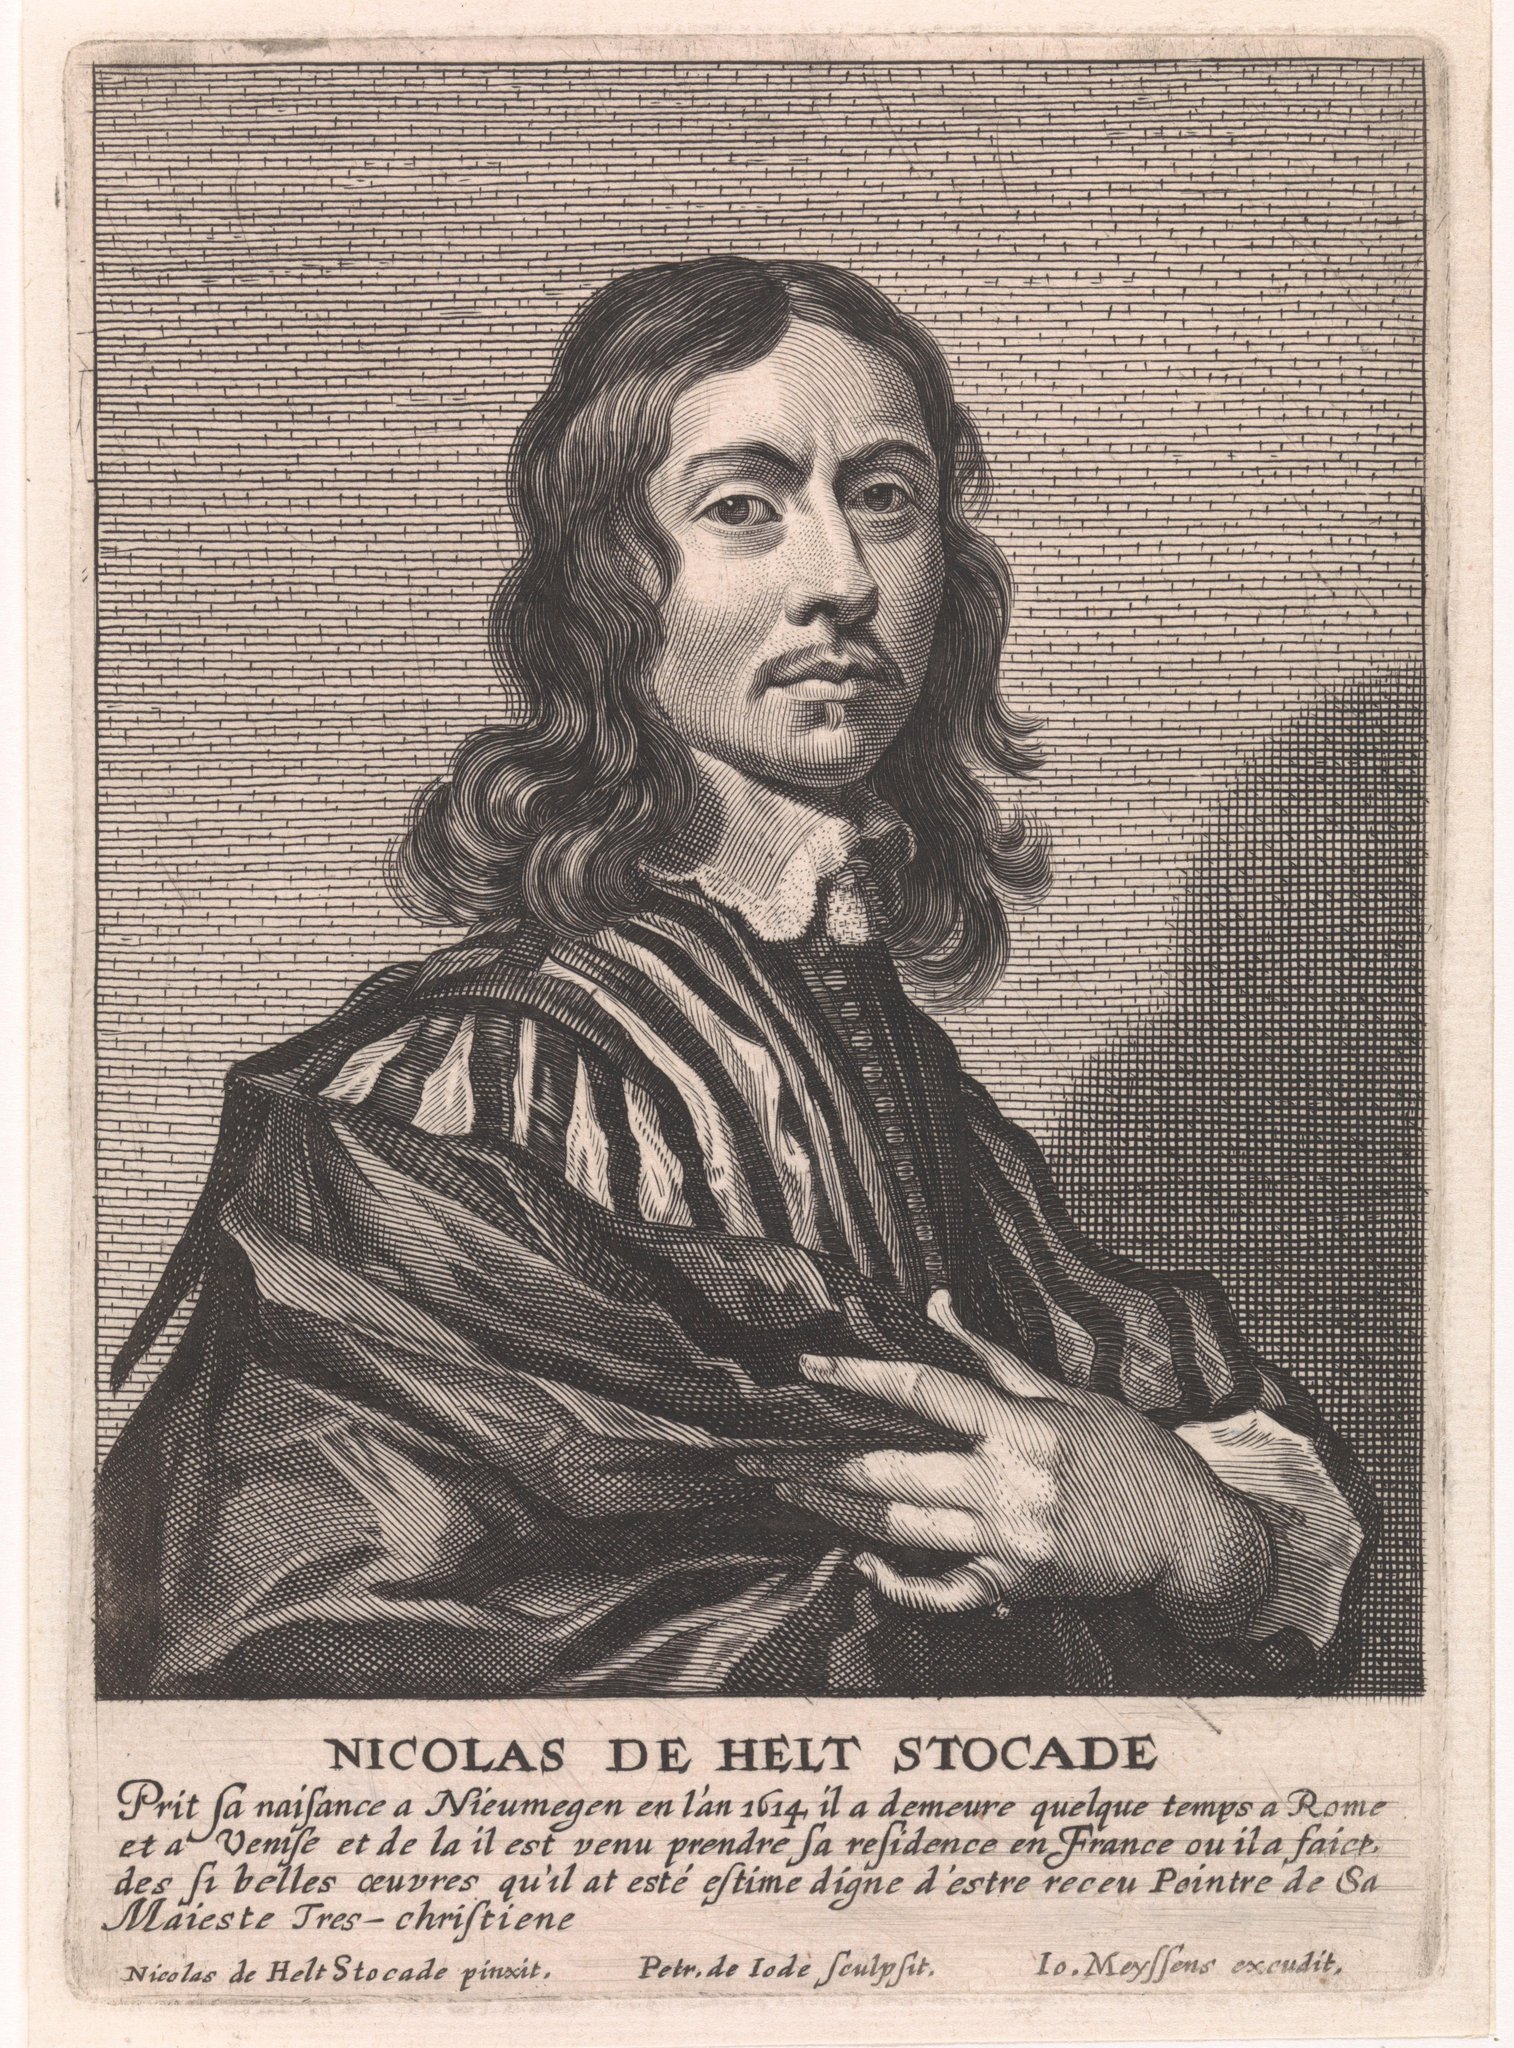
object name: print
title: Portret van Nicolaes van Helt Stocade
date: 1628-1670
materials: paper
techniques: engraving, etching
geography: antwerp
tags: nijmegen, amsterdam, nicolaes van helt stockade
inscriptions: collector's mark: Lugt 2228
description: Busteportret van de schilder Nicolaes van Helt Stocade. Hij houdt zijn linkerhand tegen zijn borst. In de marge de naam van de geportretteerde en een vierregelig onderschrift in het Frans.